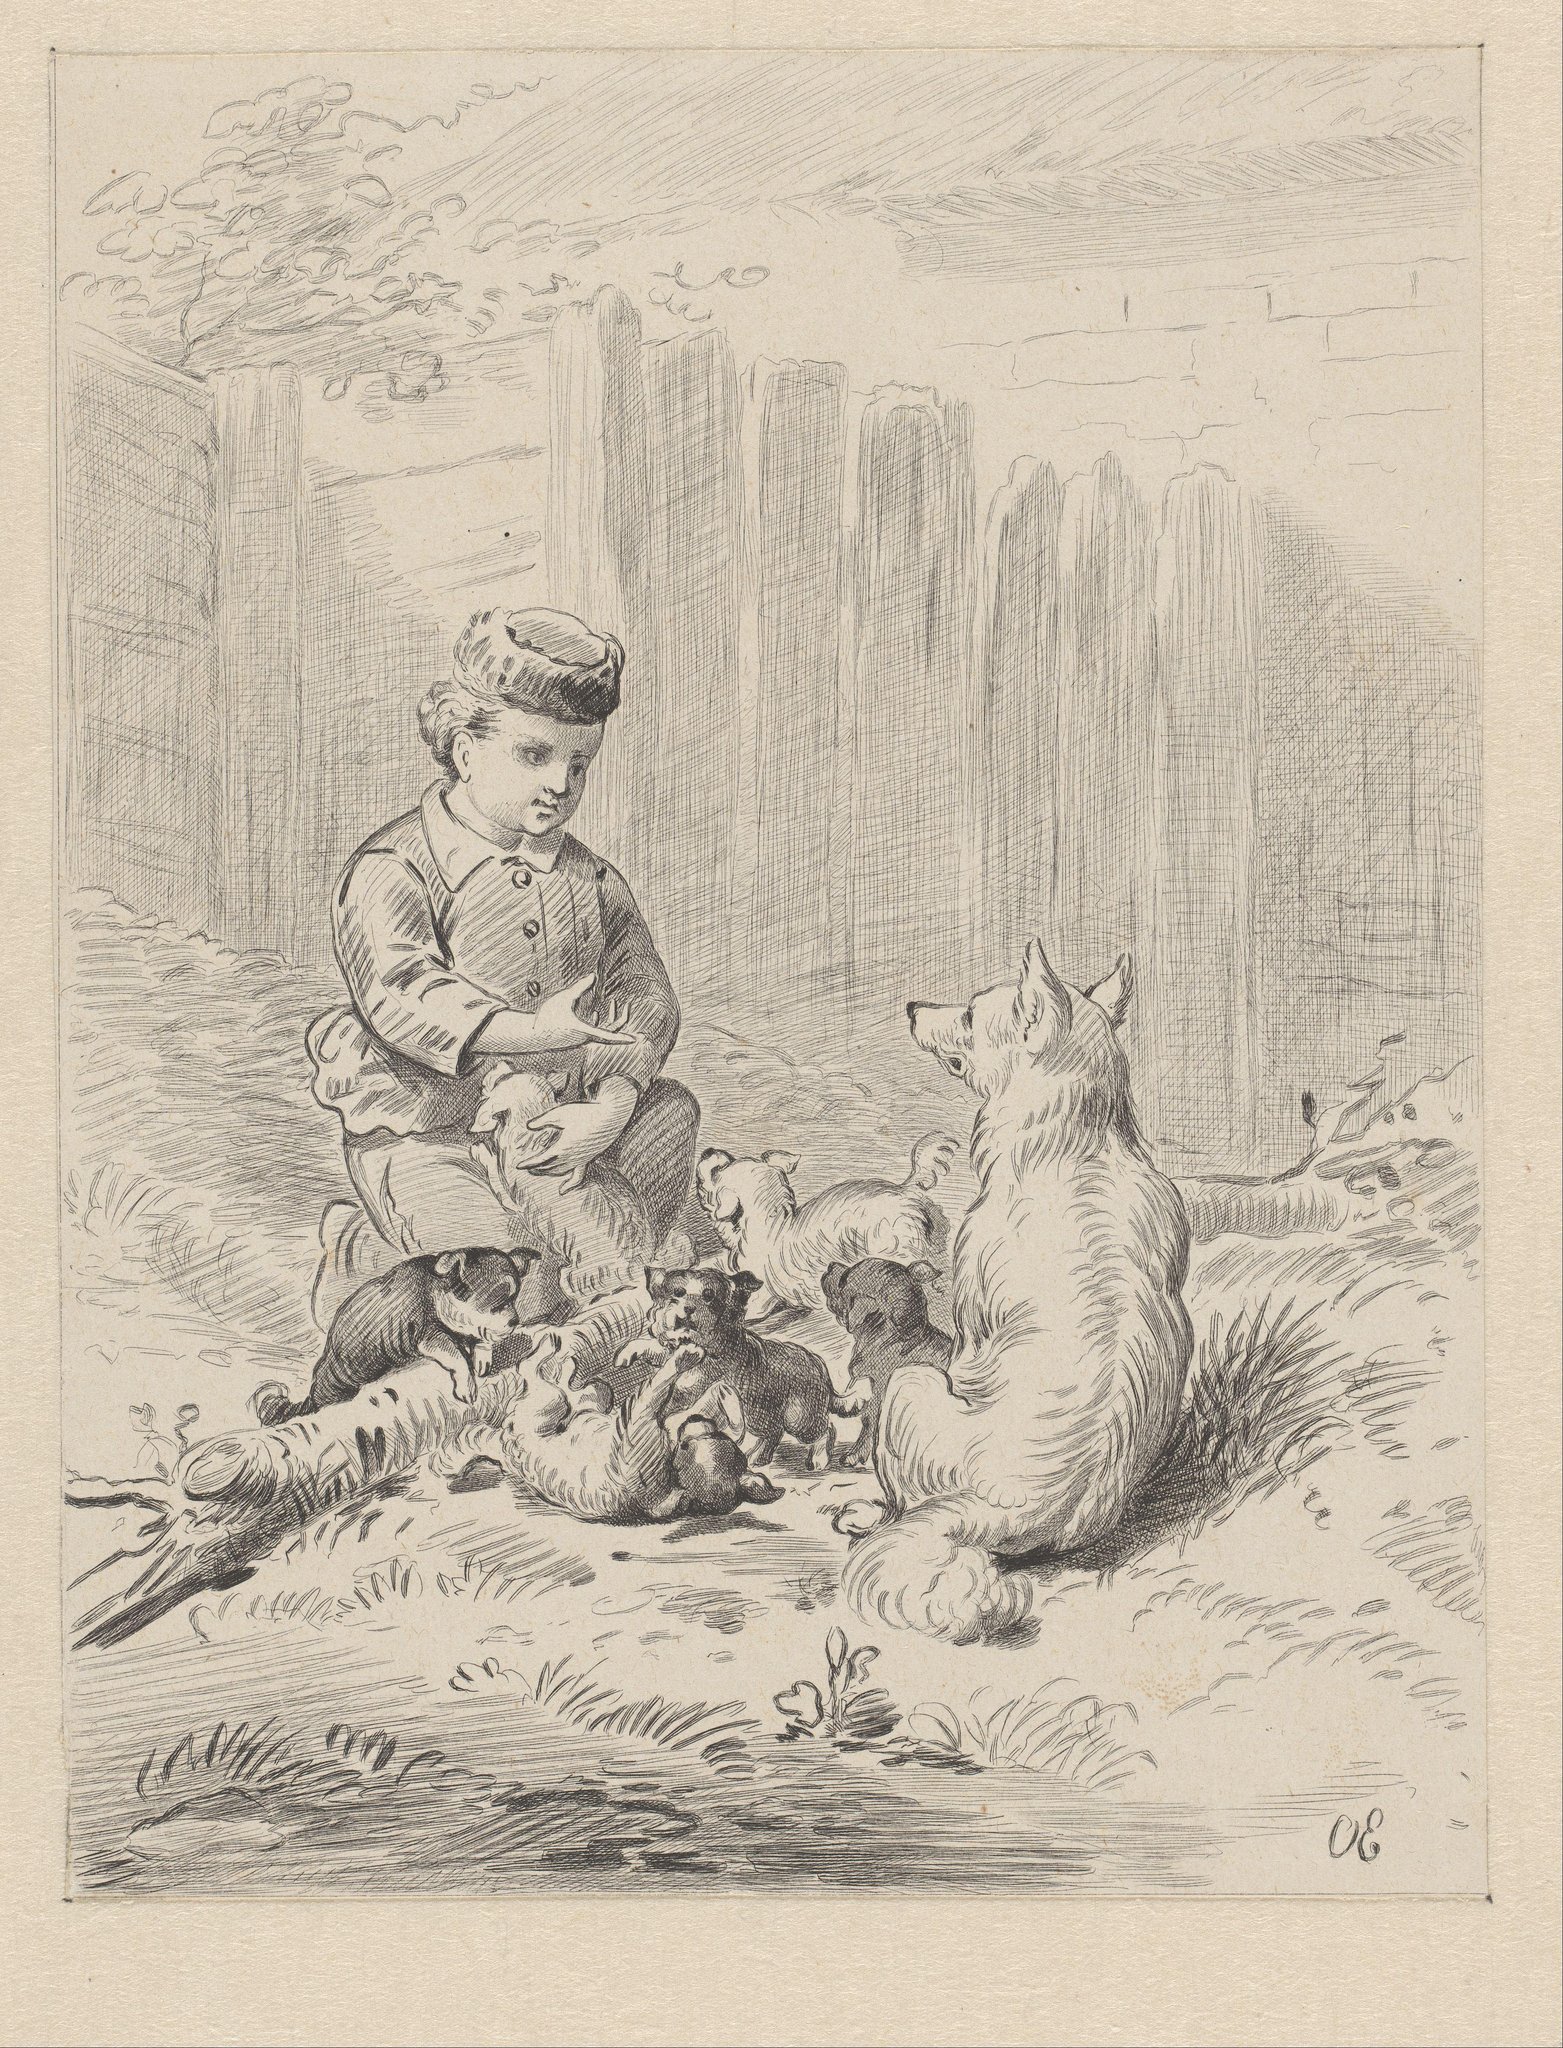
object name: print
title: Kind met honden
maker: otto eerelman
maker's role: draughtsman, painter, print maker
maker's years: 1839-1926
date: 1865-1918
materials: paper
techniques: engraving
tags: child, dog